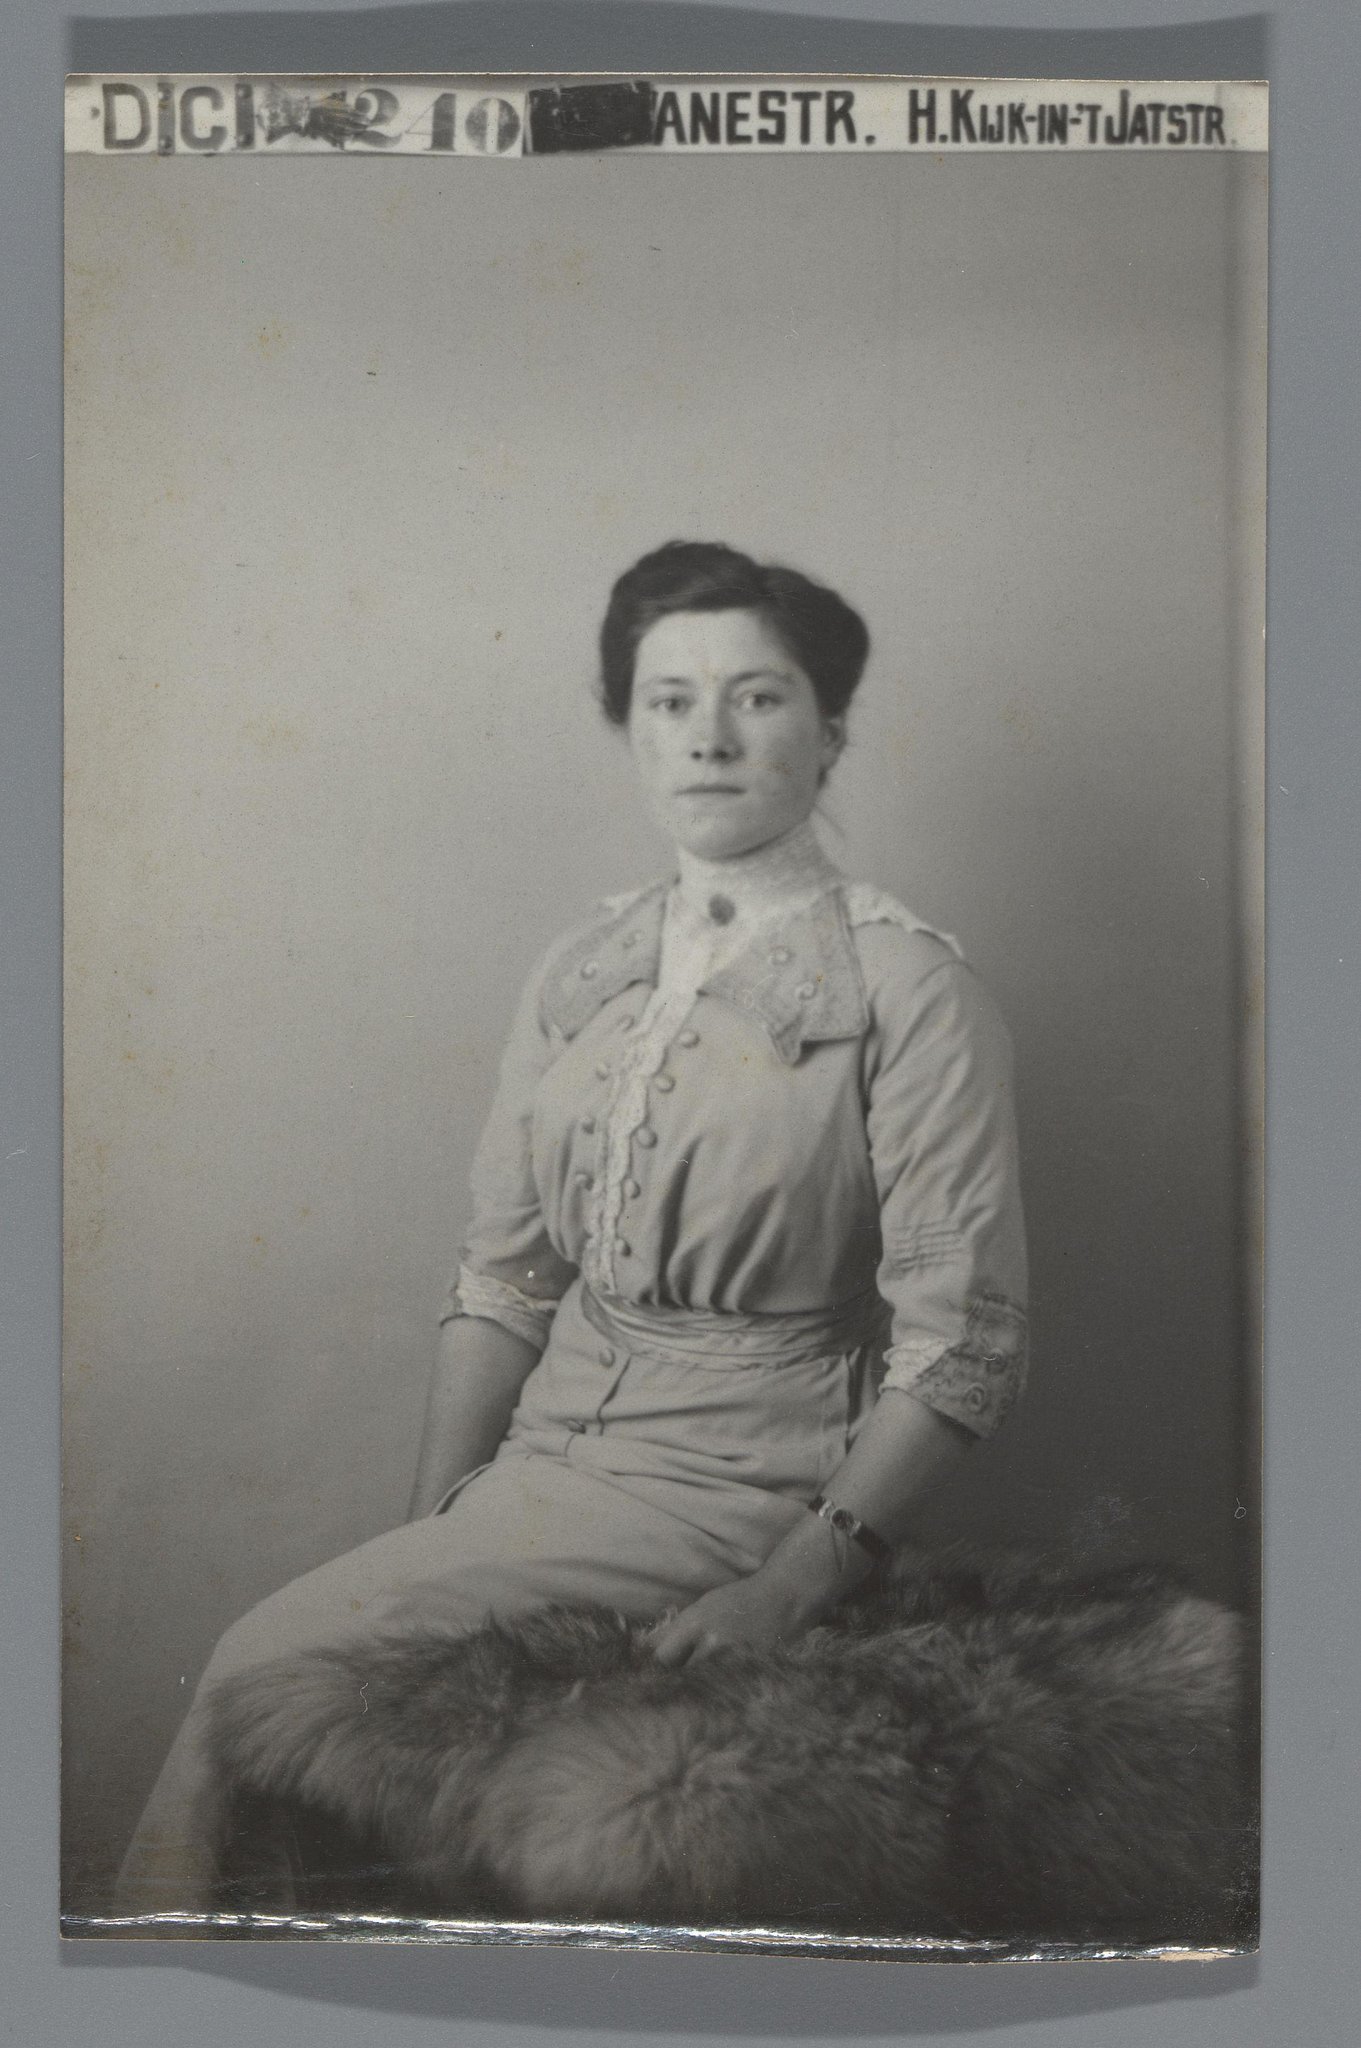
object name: snapshot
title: Portret van een vrouw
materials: photographic support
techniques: gelatin silver print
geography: groningen